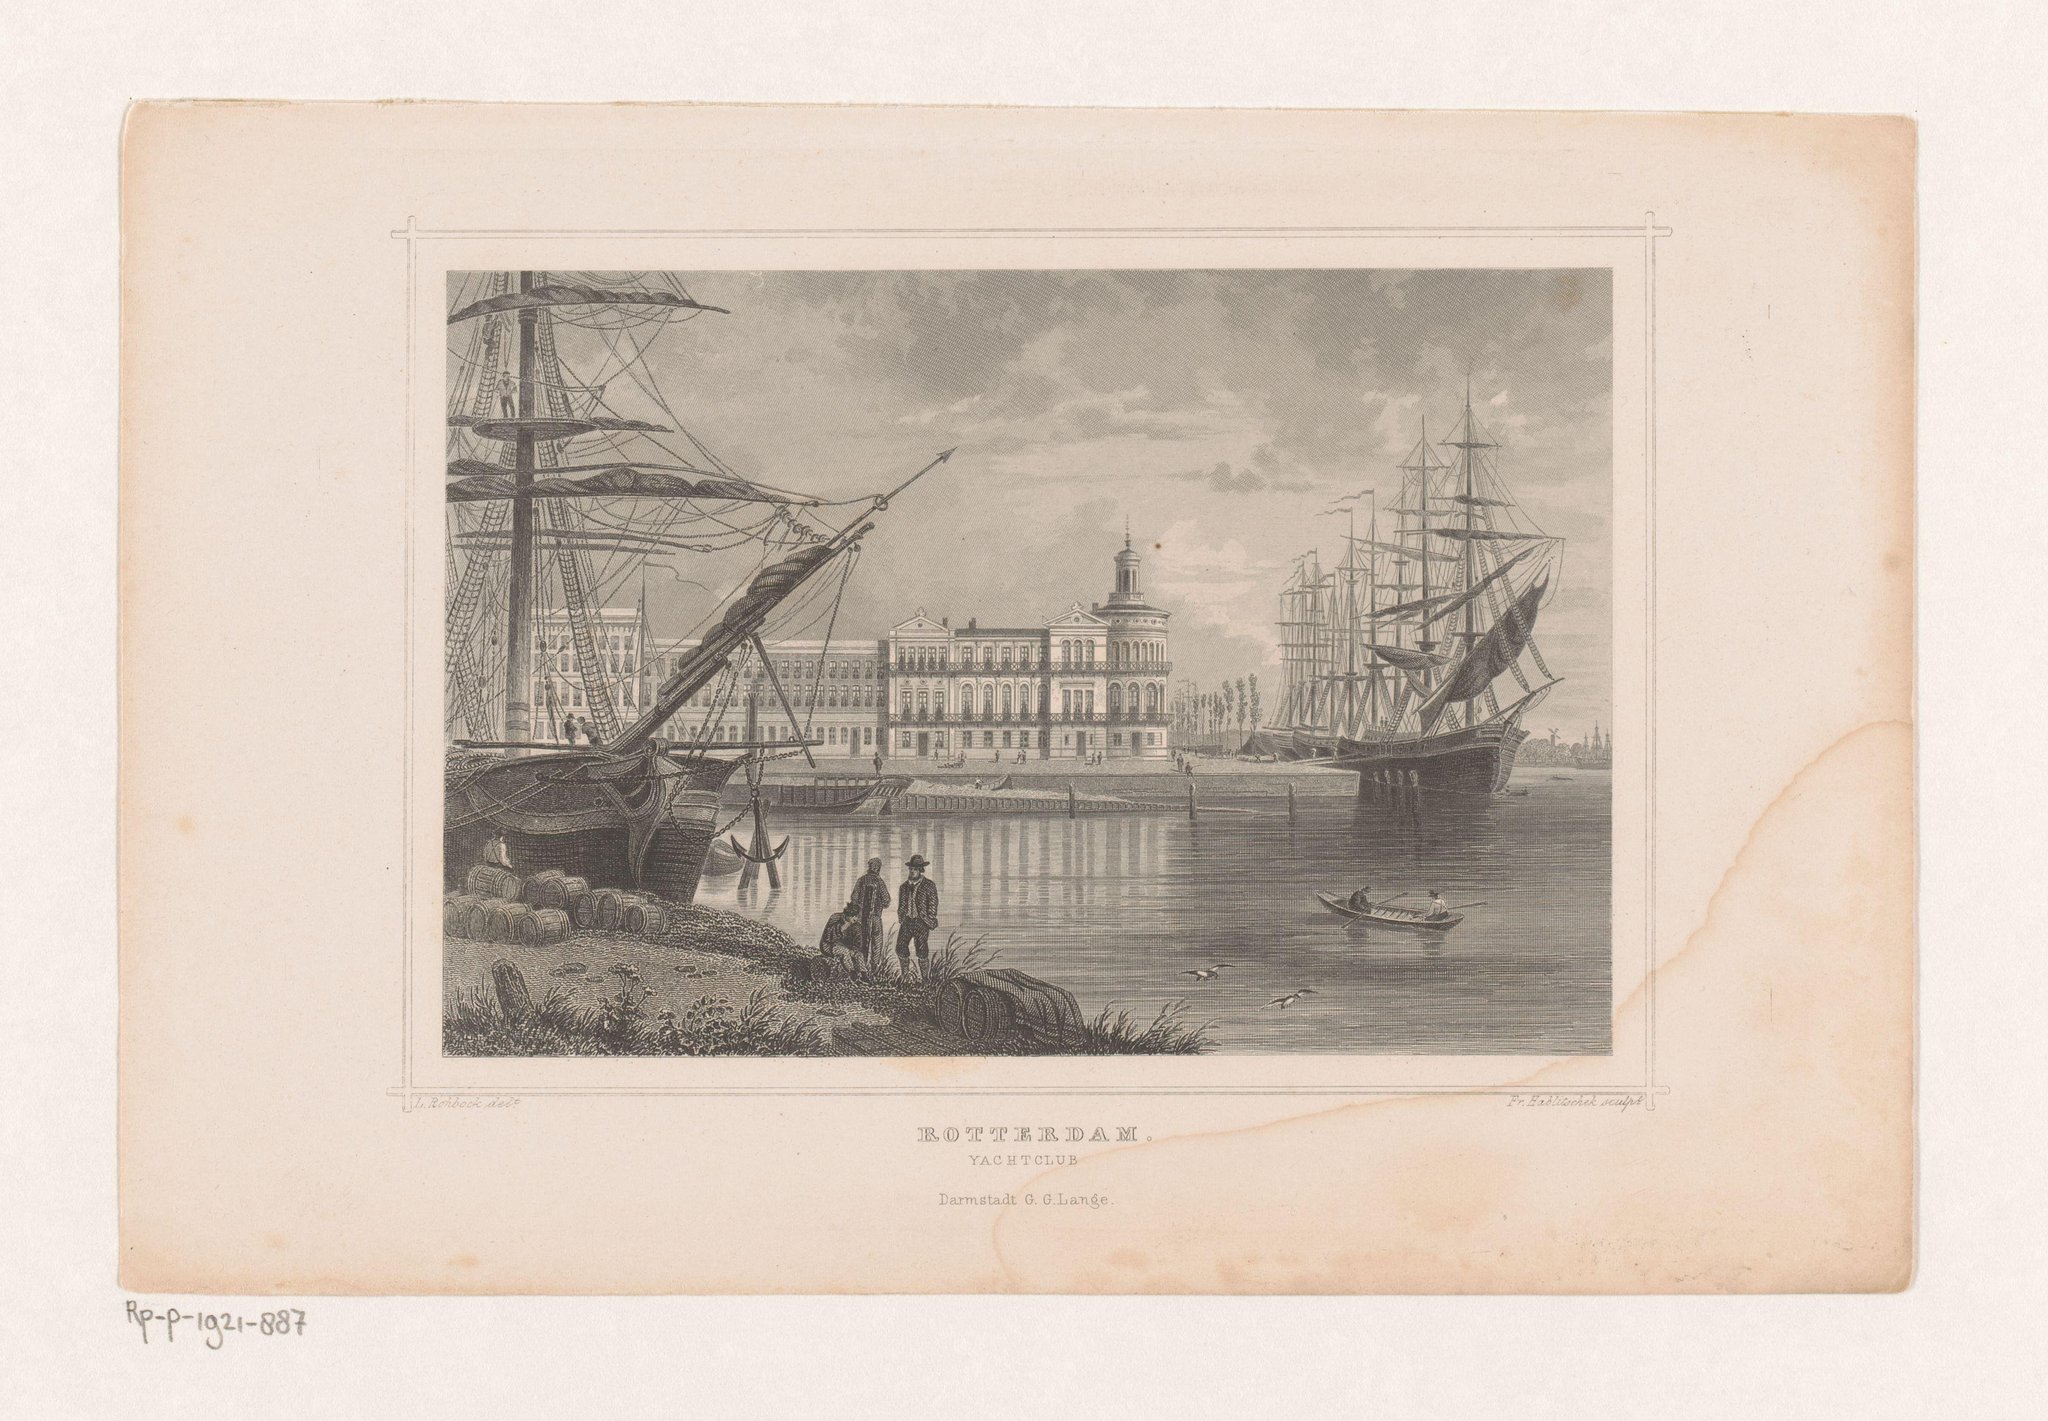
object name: print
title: Gezicht op de Veerhaven te Rotterdam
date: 1834-1867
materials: paper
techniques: engraving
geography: darmstadt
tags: harbour, city-view in general; 'veduta', ships (in general)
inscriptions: collector's mark: Lugt 2233